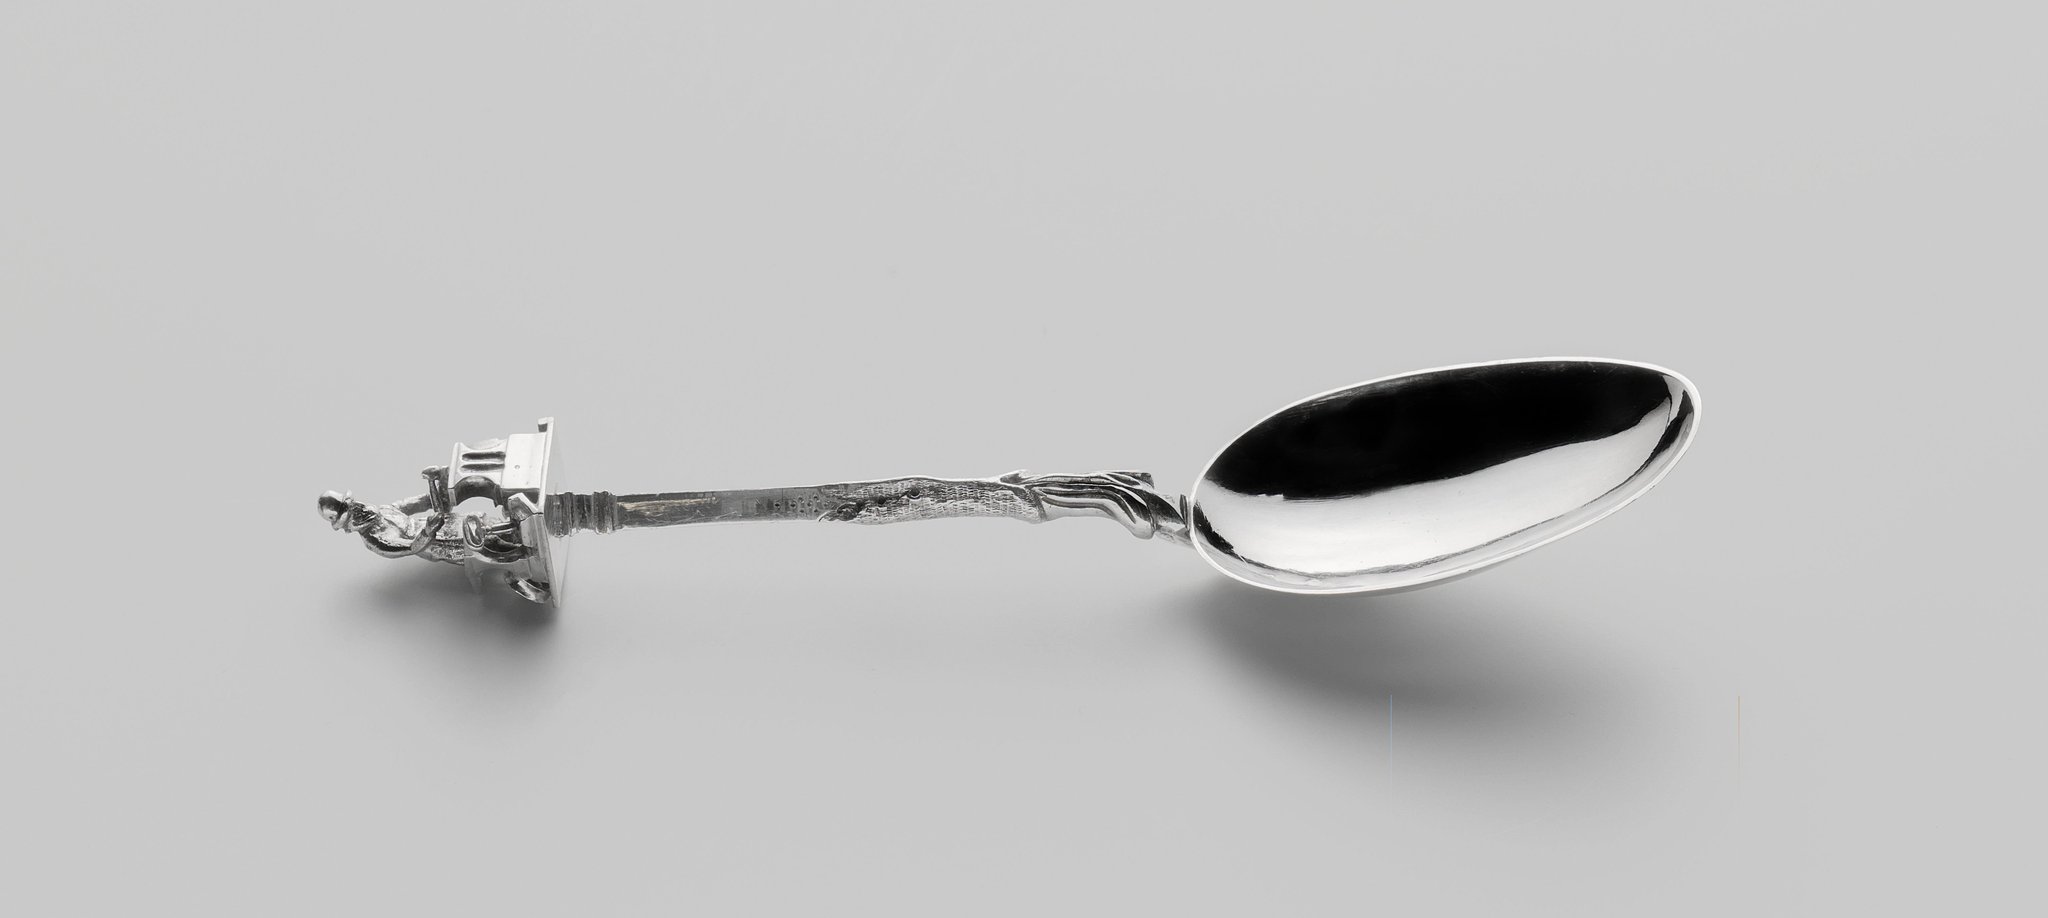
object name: spoon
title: Lepel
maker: Anonymous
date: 1740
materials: silver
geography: enkhuizen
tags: enkhuizen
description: Zilveren lepel met ovalen bak, en een doorsnede driehoekige steel. Merken: Enkhuizen, zittende vogel. Twee tekens waarvan één een D in een cirkel, de andere onleesbaar. Nederland omstreeks 1740. De steel wordt bekroond door een voorstelling van een smid achter zijn aanbeeld.